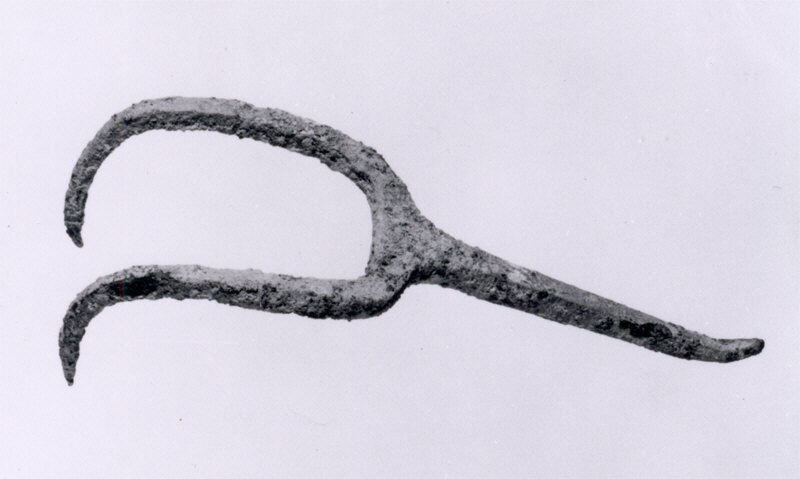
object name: fork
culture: bactria-margiana archaeological complex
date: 2333-1668 BCE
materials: copper alloy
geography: bactria-margiana